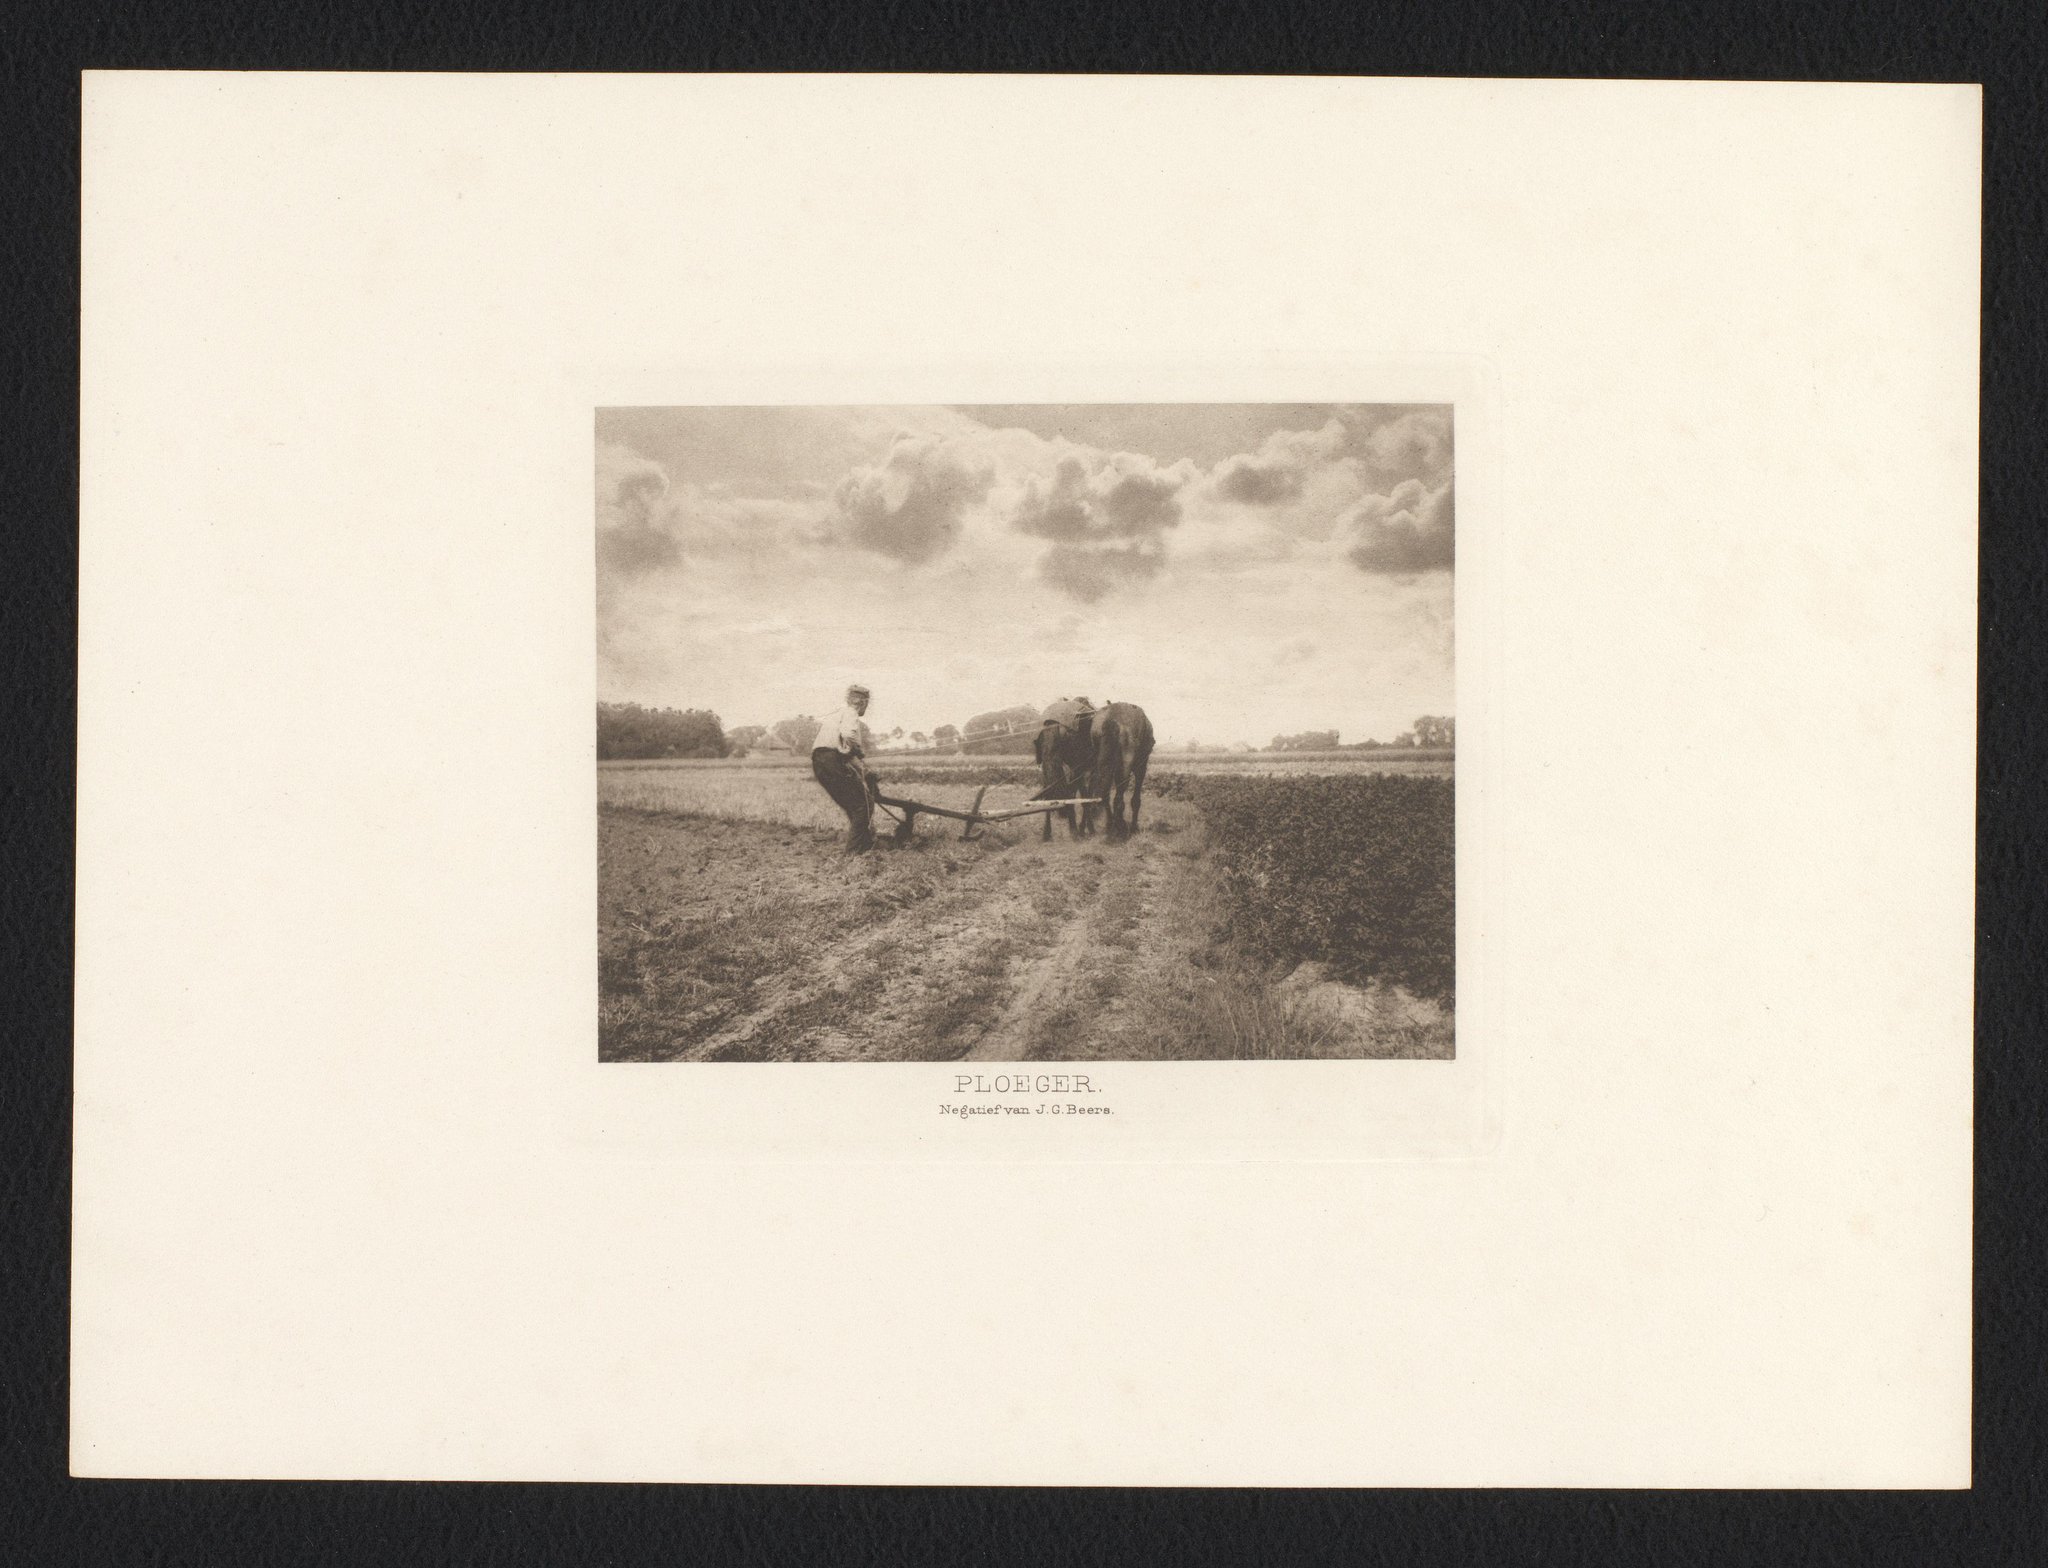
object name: photomechanical print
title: Boer met paarden en ploeg op een akker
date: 1899-1904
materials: paper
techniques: photoaquatint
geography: netherlands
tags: horse, agriculture, ploughing